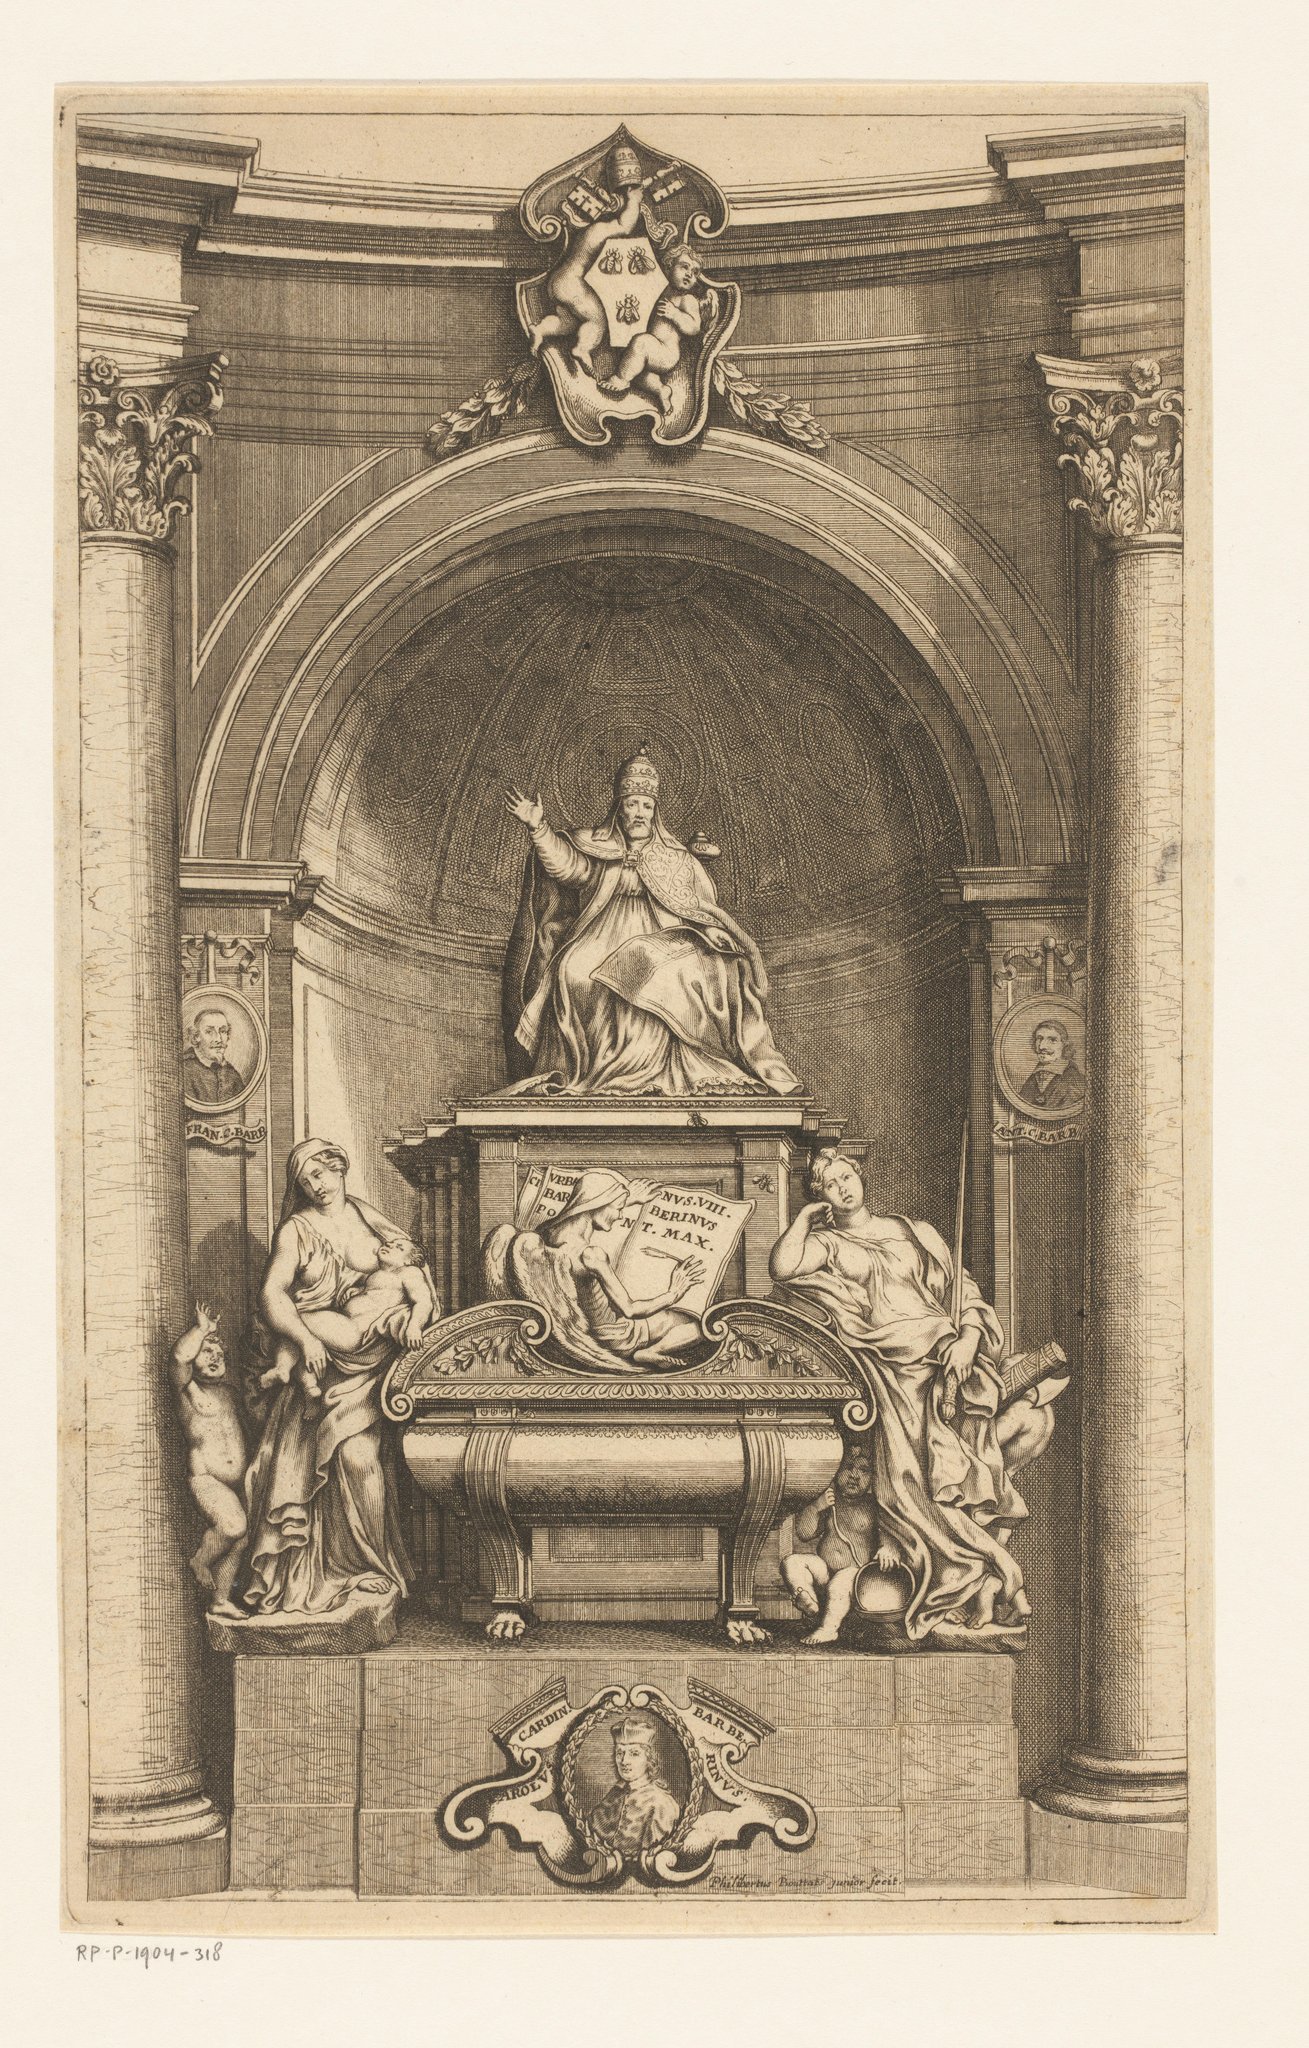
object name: print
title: Graftombe van Paus Urbanus VIII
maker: philibert bouttats (ii)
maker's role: print maker, publisher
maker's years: 1675-1750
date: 1685-1736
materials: paper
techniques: engraving, etching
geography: rome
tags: naples, rome, painter, draughtsman, sculptor, gian lorenzo bernini, clergyman, urbanus viii, charity, 'caritas'; 'carità' (ripa) ~ one of the three theological virtues, justice, 'justitia'; 'giustitia divina' (ripa) ~ one of the four cardinal virtues, death as skeleton, grave-building, monumental tomb, pope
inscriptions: signature: ‘Philibertus Bouttats Junior fecit’, collector's mark: Lugt 2228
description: Graftombe van Paus Urbanus VIII in de Sint-Pietersbasiliek van Rome, door Bernini. Boven op de tombe het zittend standbeeld van Urbanus VIII. Hij maakt een zeggenend gebaar. Links het standbeeld van Caritas, rechts dat van Justitia. In het midden van de tombe de dood die in een boek de naam van de overledene schrijft. Boven de tombe het persoonlijk pauselijk wapen van Urbanus VIII, opgehouden door twee putti. Links, rechts van en onder de tombe portretten van andere leden van Barberini-familie